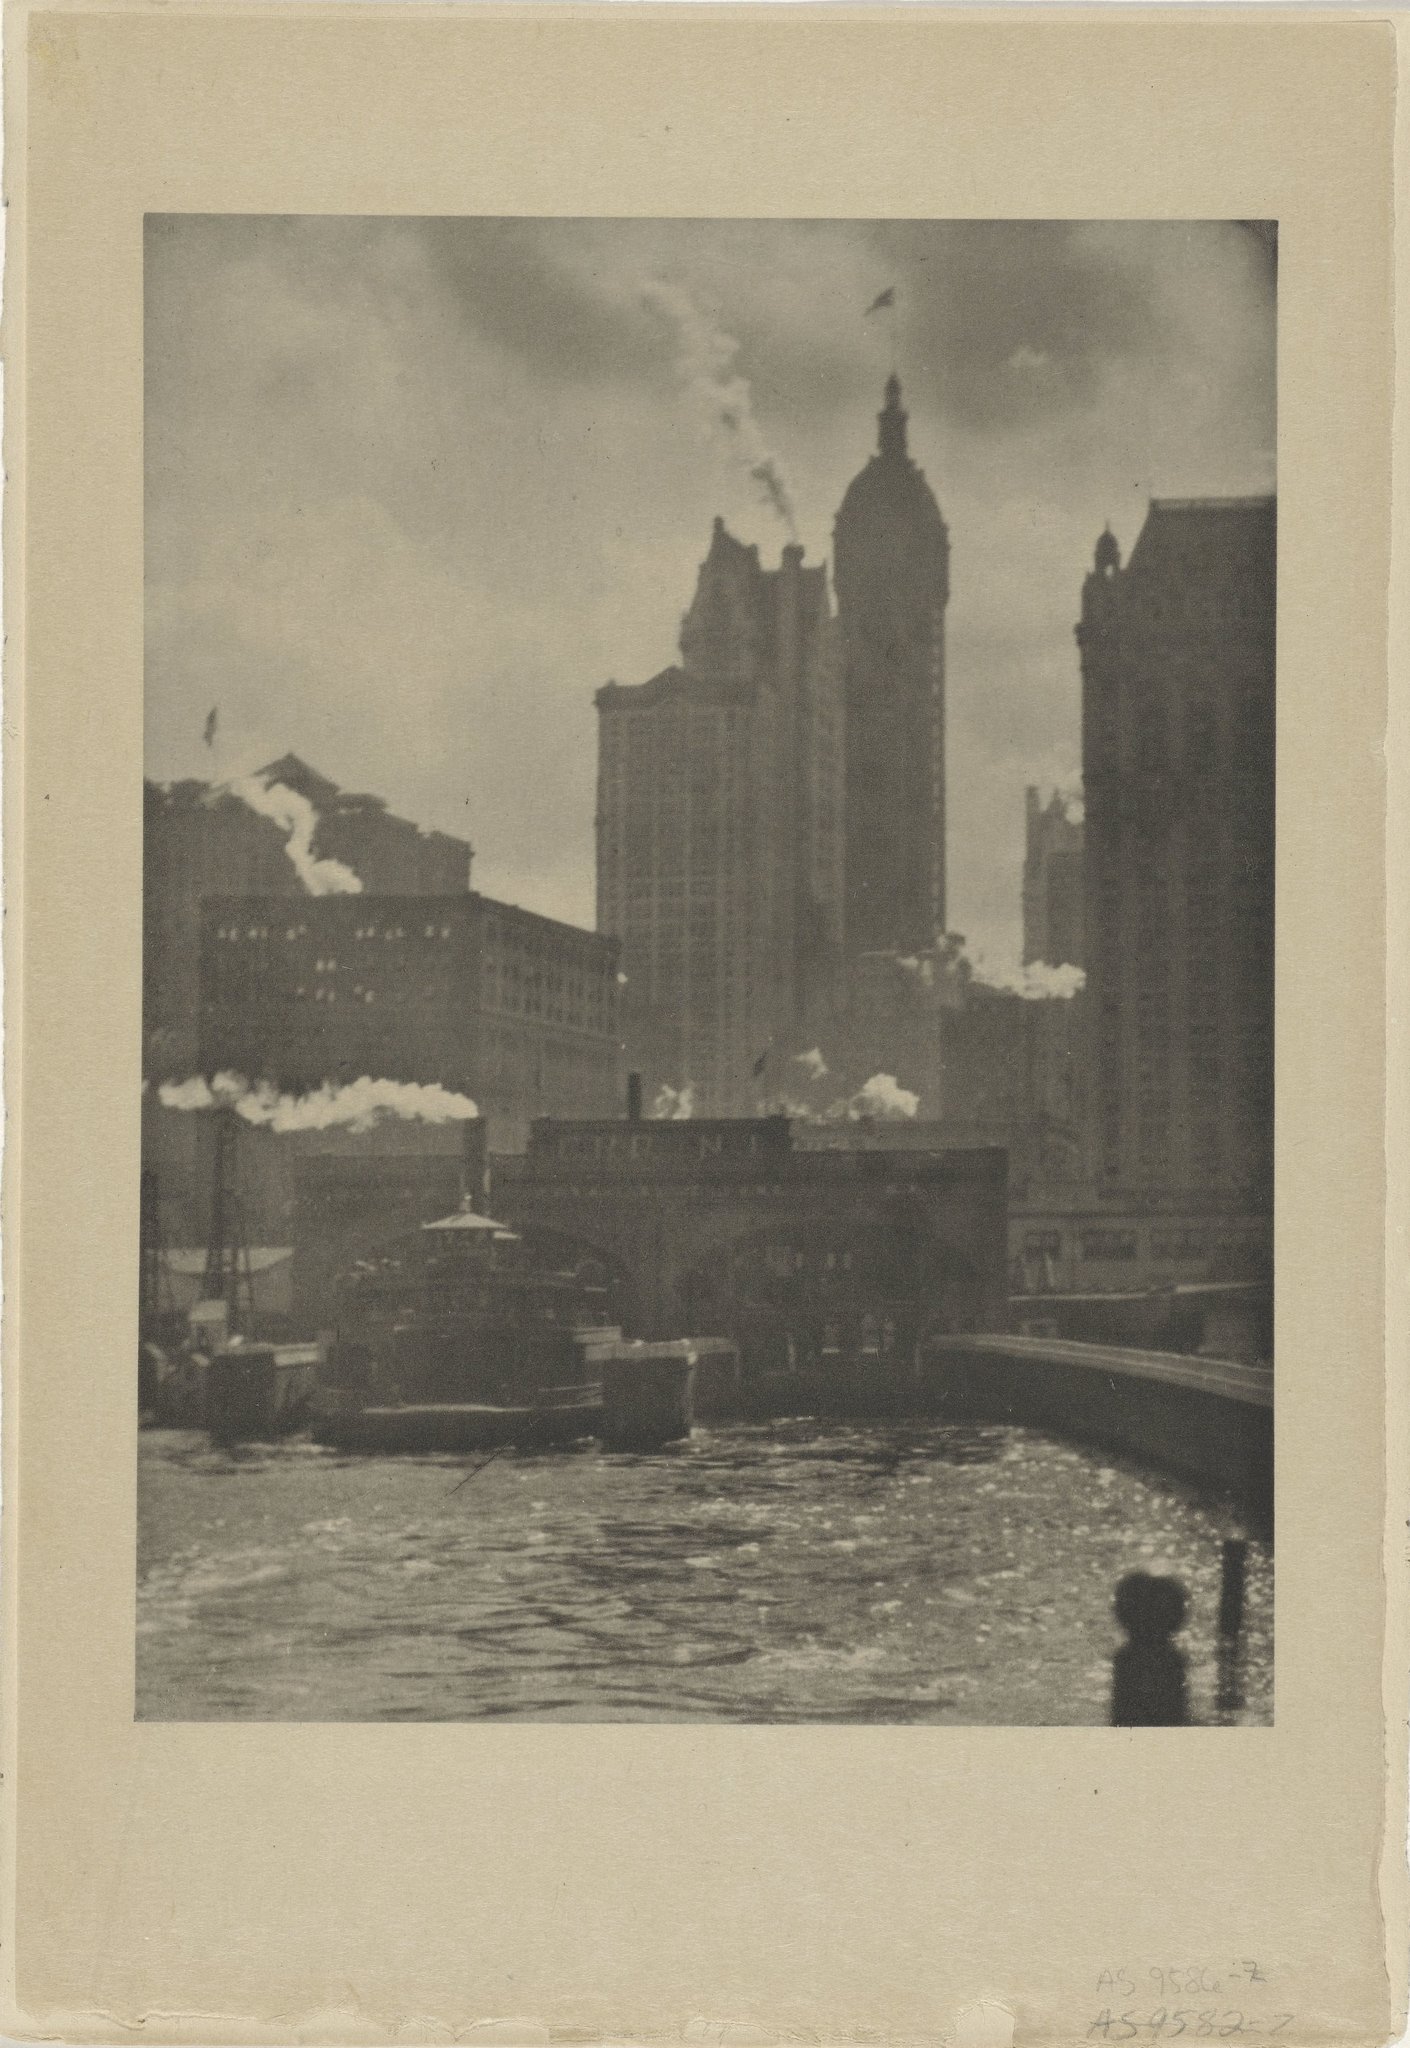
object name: photomechanical print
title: Stadsgezicht van New York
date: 1911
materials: paper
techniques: photoaquatint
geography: new york city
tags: city-view in general; 'veduta', new york (city)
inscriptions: number: ‘AS 9584/ AS 9582-2’, number: ‘AS 70767 (A)’